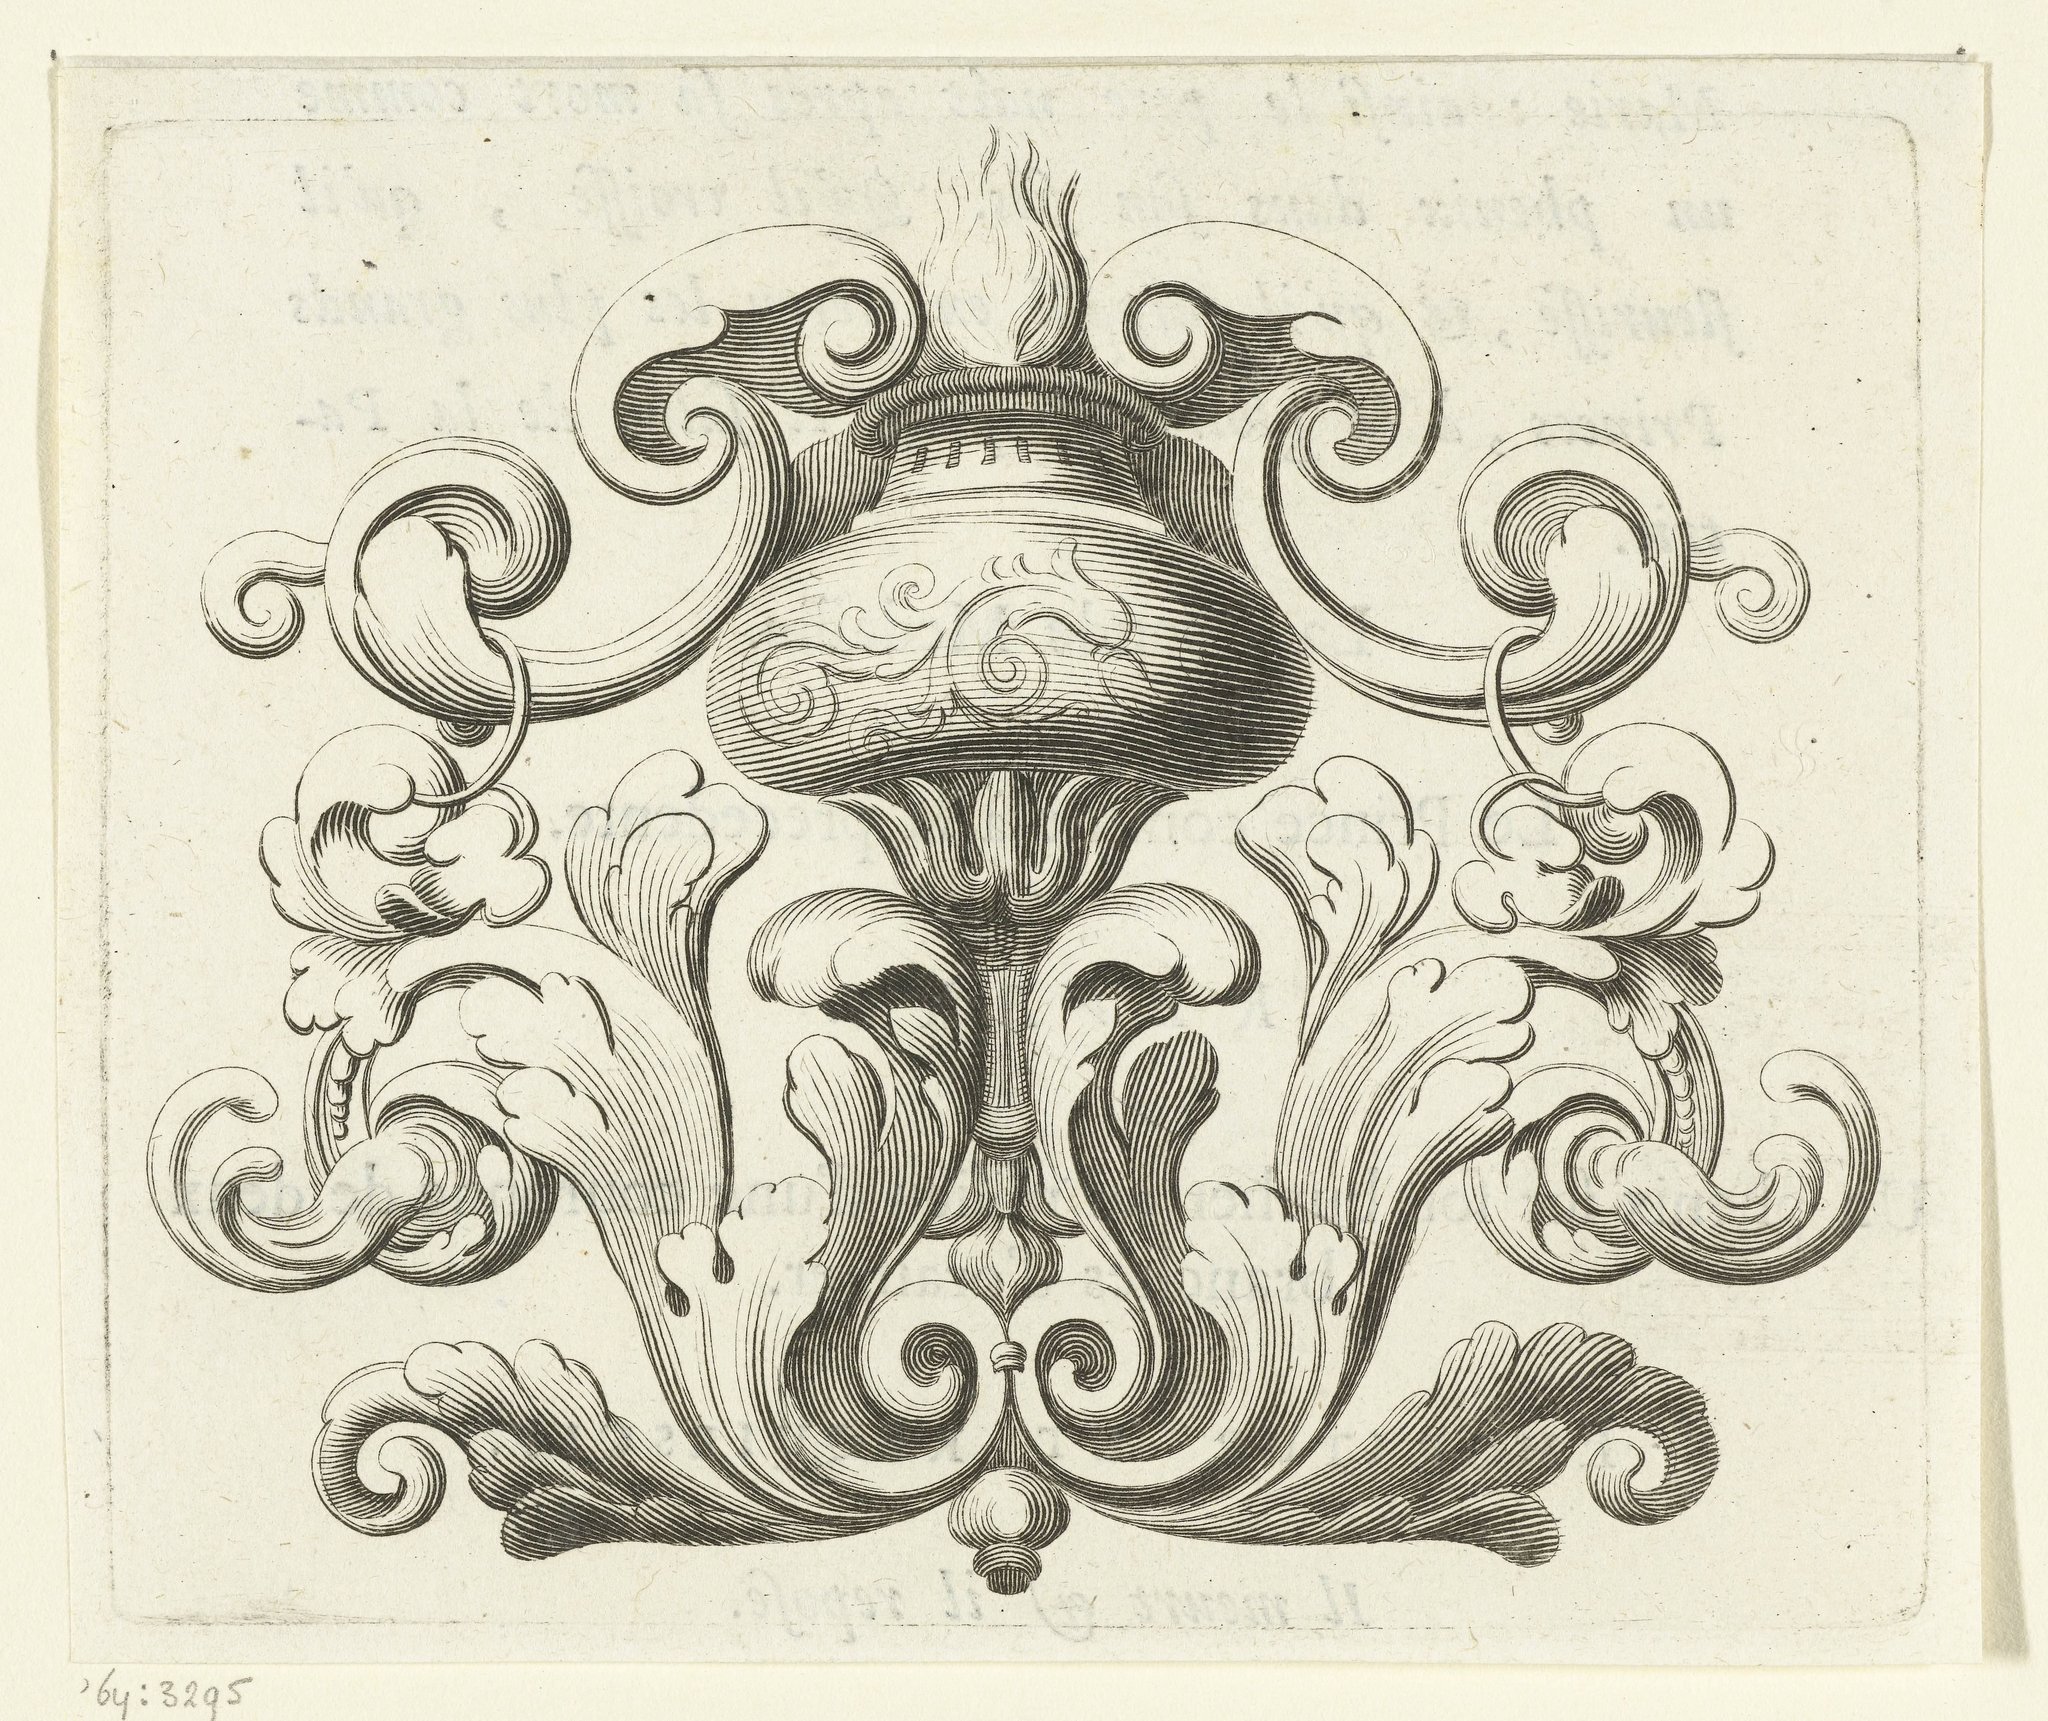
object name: ornament print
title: Fakkel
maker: Anonymous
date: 1688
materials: paper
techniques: etching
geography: netherlands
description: De fakkel is gedecoreerd met bladranken. Uit serie vignetten met zeegoden en allegorieën, als illustratie gebruikt in het boek Histoire metallique de la république de Hollande van P. Bizot.